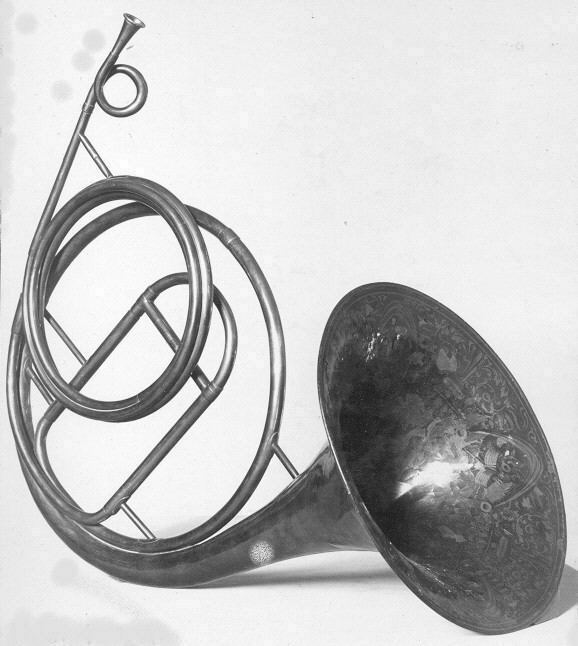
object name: orchestral horn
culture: french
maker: tabard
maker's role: maker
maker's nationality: french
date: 1830-1840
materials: brass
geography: france